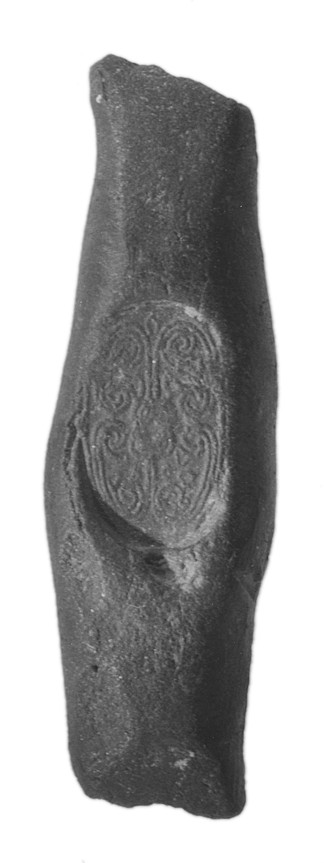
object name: sealing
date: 2030-1640 BCE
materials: clay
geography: egypt